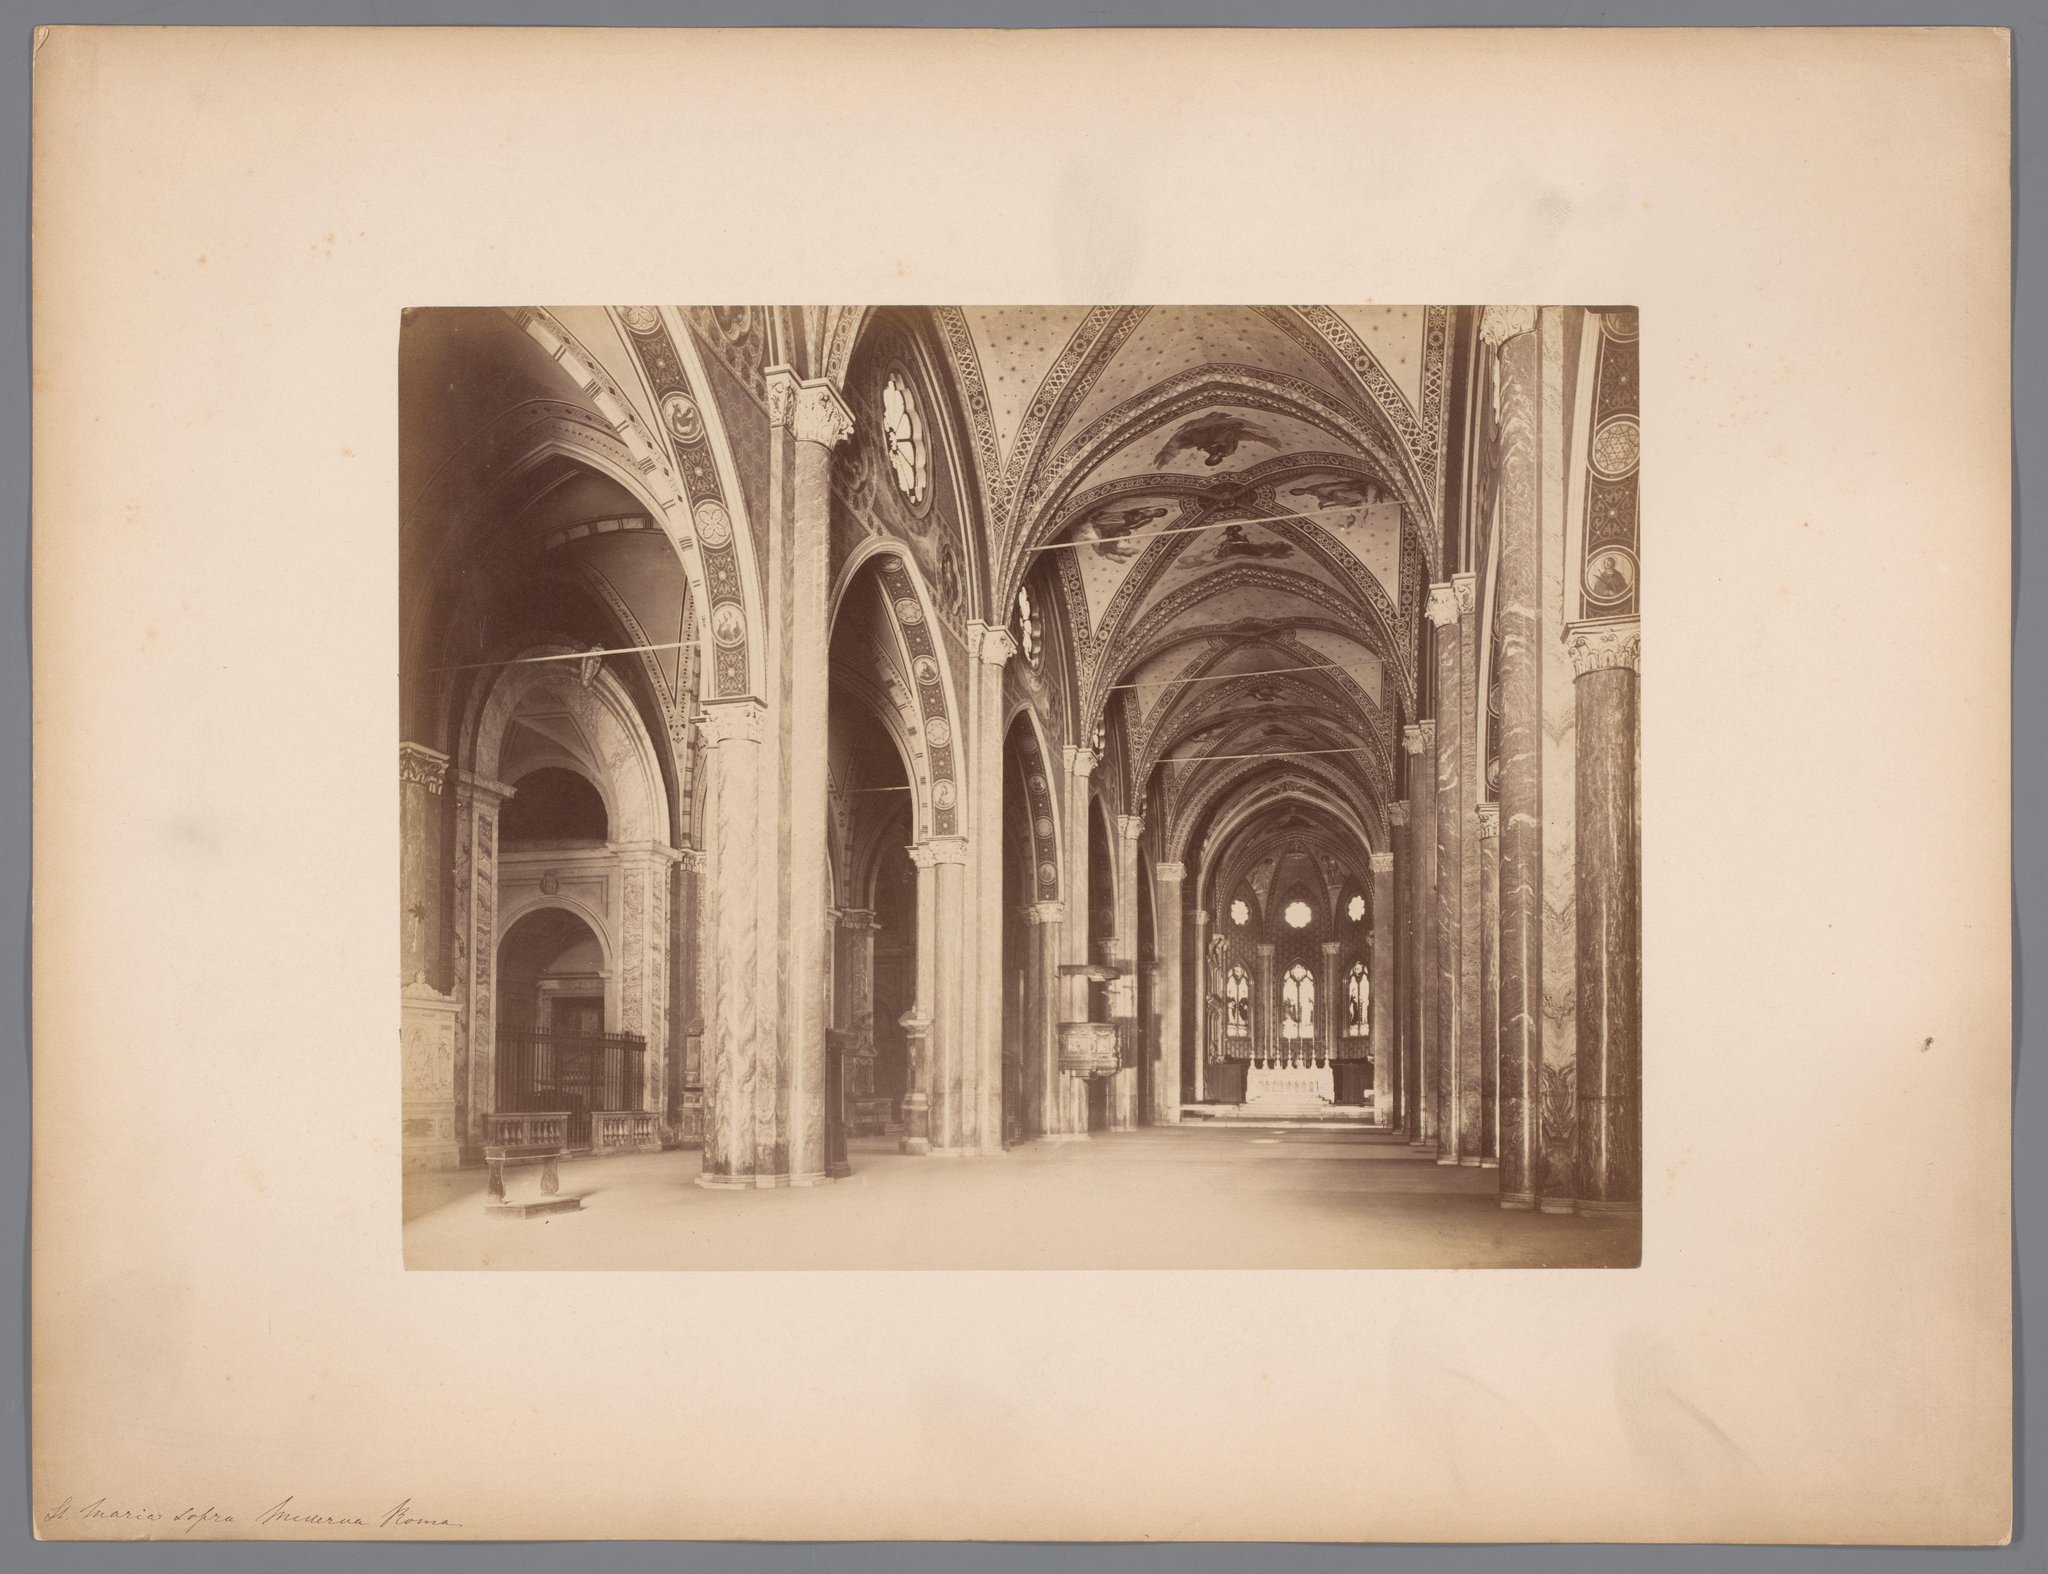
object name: photograph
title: Interieur van de Santa Maria sopra Minera te Rome, Italië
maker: Anonymous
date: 1851-1900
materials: cardboard, paper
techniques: albumen print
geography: rome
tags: interior of church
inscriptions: number: ‘30’